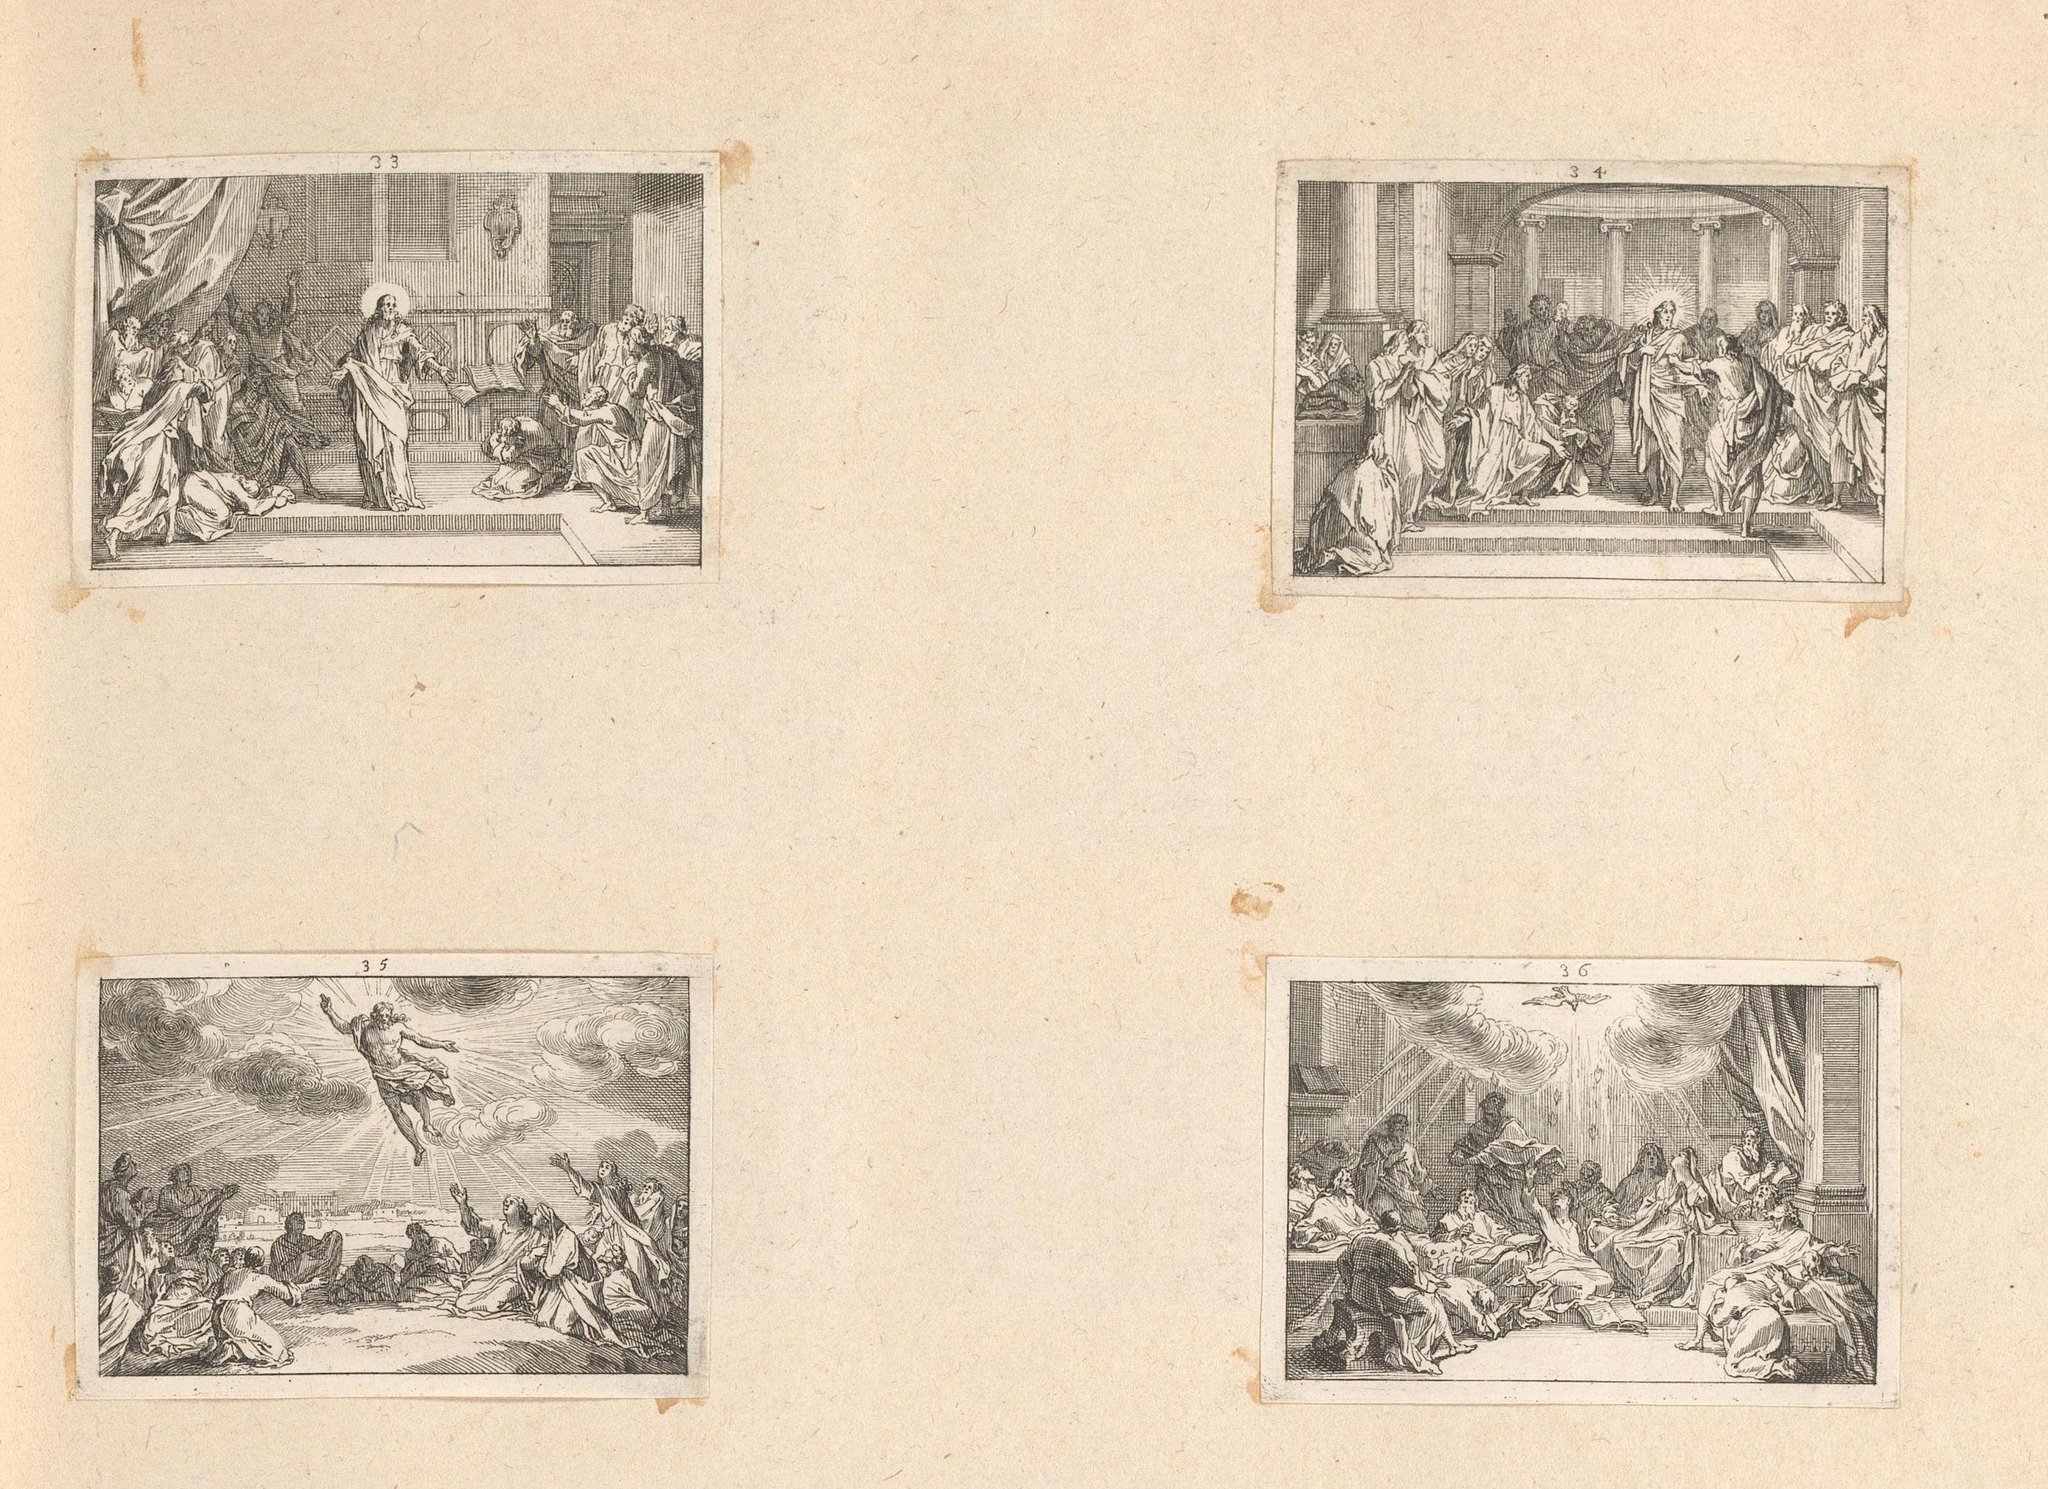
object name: album leaf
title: Figures de la Passion D.N.S. Jesus Christ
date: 1647-1703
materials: paper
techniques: engraving, etching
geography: france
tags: passion of christ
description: Deze prenten maken deel uit van een serie met 36 voorstellingen van de Passie, opgedragen aan Madame de Maintenon. In het album bevinden zich verschillende staten van de serie: latere staten met de ornamentele lijst en eerdere staten zonder de ornamentele lijst.